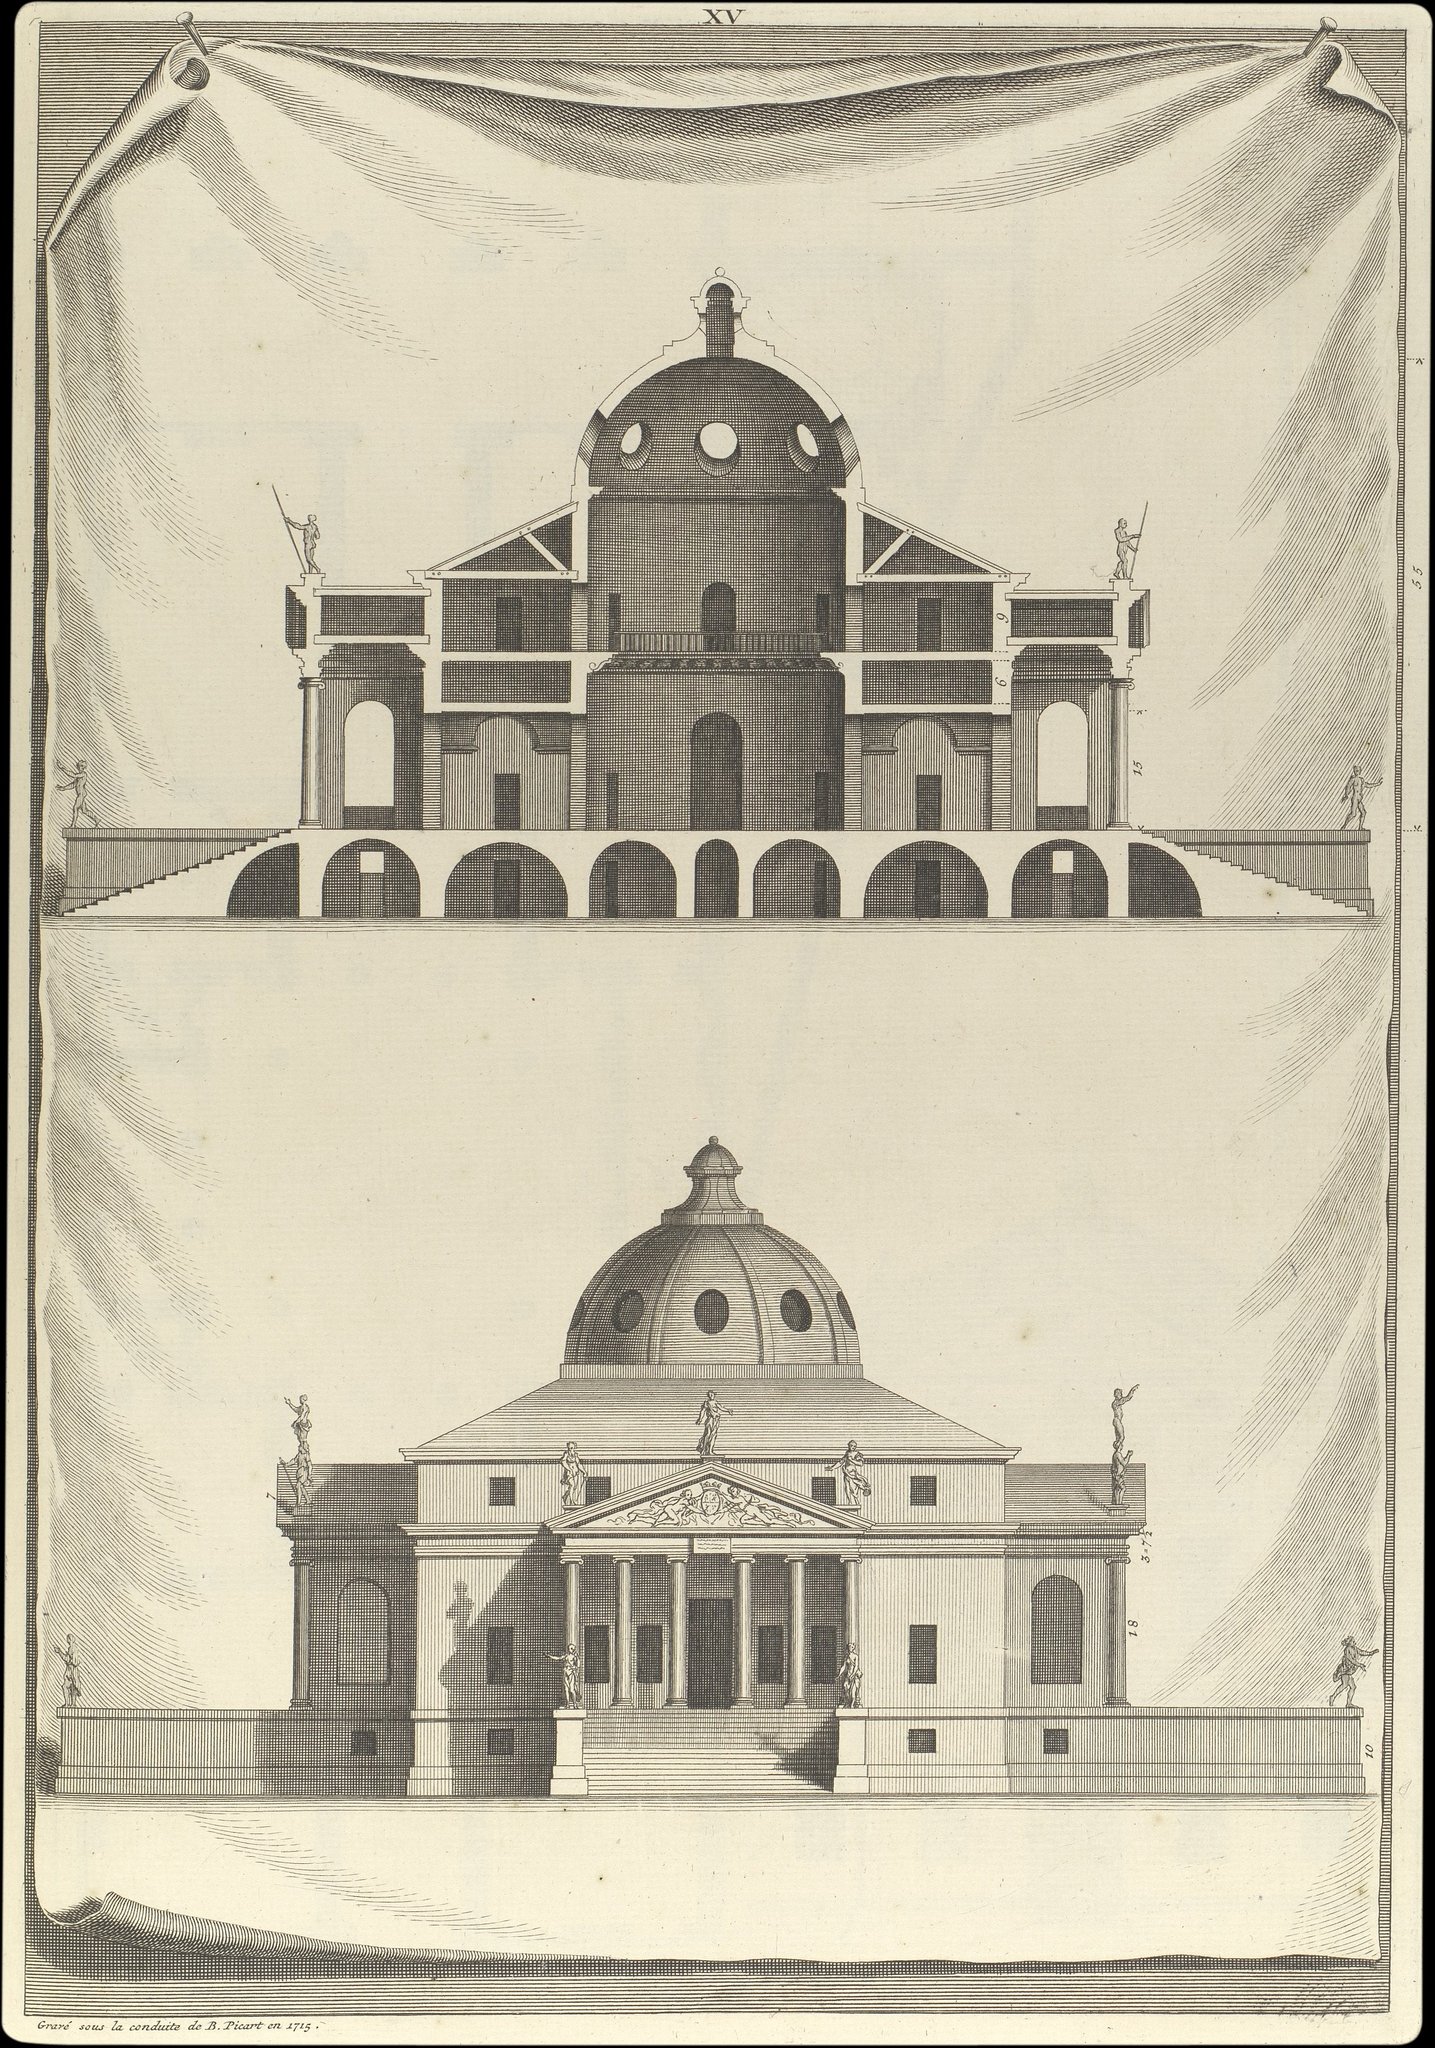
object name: book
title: Villa Rotunda, in The Architecture of A. Palladio in Four Books containing a Short Treatise on the Five Orders (L'Architecture de A. Palladio en quatre livres... / Il quattro libri dell'architettura) (Volume 1, book 2, plate 15)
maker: andrea palladio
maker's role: author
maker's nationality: italian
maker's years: 1508-1580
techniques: engraving, etching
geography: england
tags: architecture